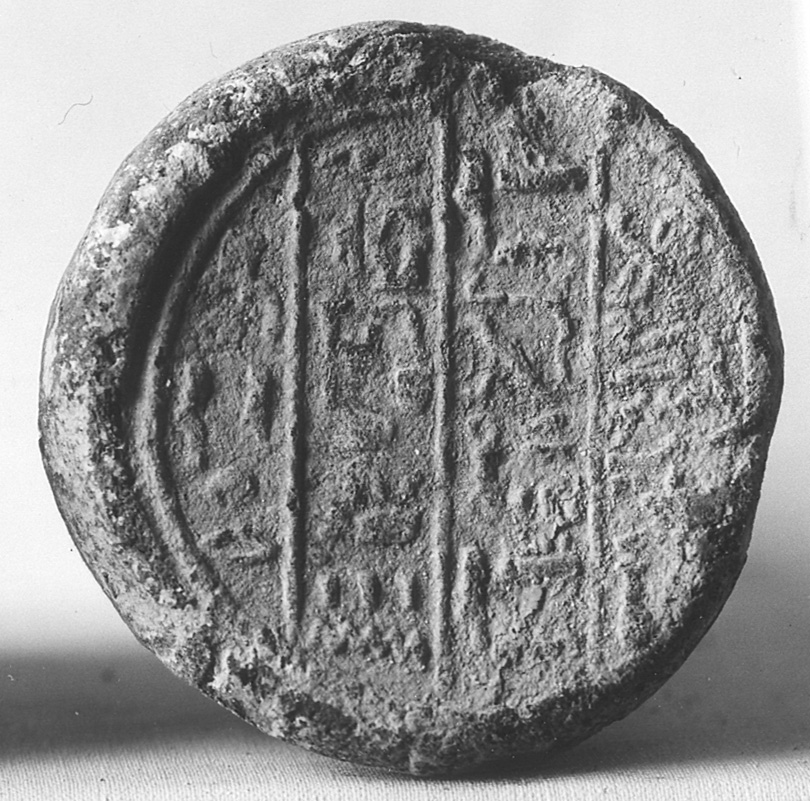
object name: cone, circular impression, amenemopet, tjanefer, scribe, amun, overseer, field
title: Funerary Cone of the Scribe Amenemopet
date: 1550-1352 BCE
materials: pottery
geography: egypt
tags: hieroglyphs